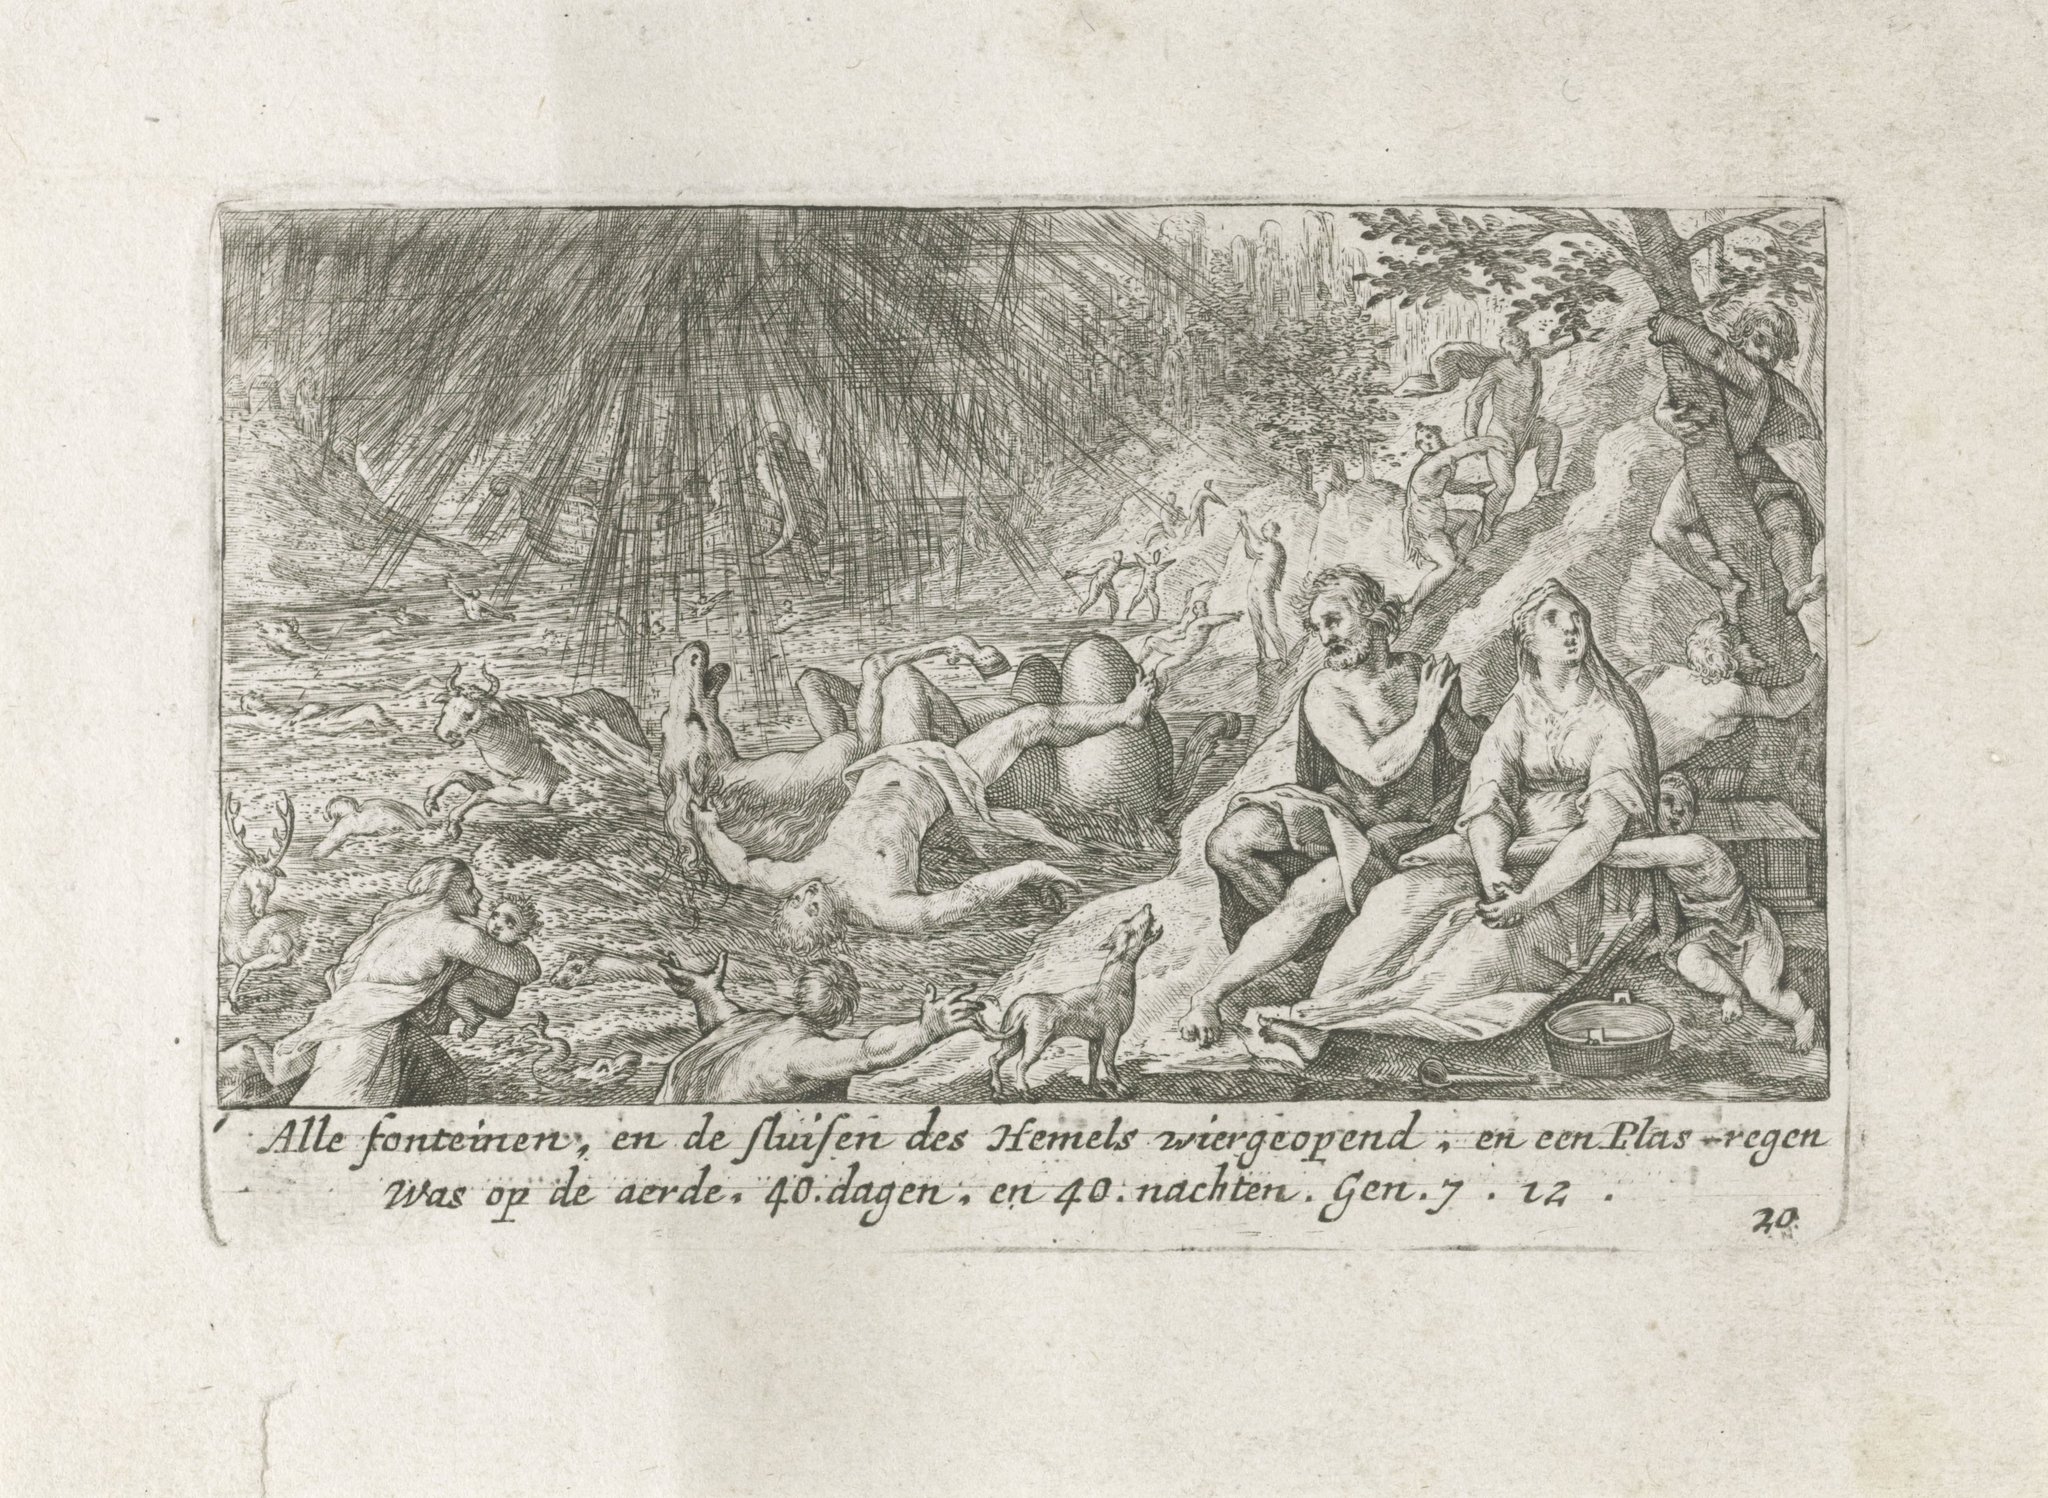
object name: print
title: Liber Genesis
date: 1700-1750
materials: paper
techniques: engraving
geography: utrecht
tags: the ark floating on the waters (destruction of mankind not visible)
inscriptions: collector's mark: Lugt 2233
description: Een stortregen overstroomt het land, veertig dagen en veertig nachten lang. Mensen en dieren worden verzwolgen door het water. Op de achtergrond de ark die de opvarenden redt voor de zondvloed. In de marge een tweeregelig onderschrift in het Nederlands.